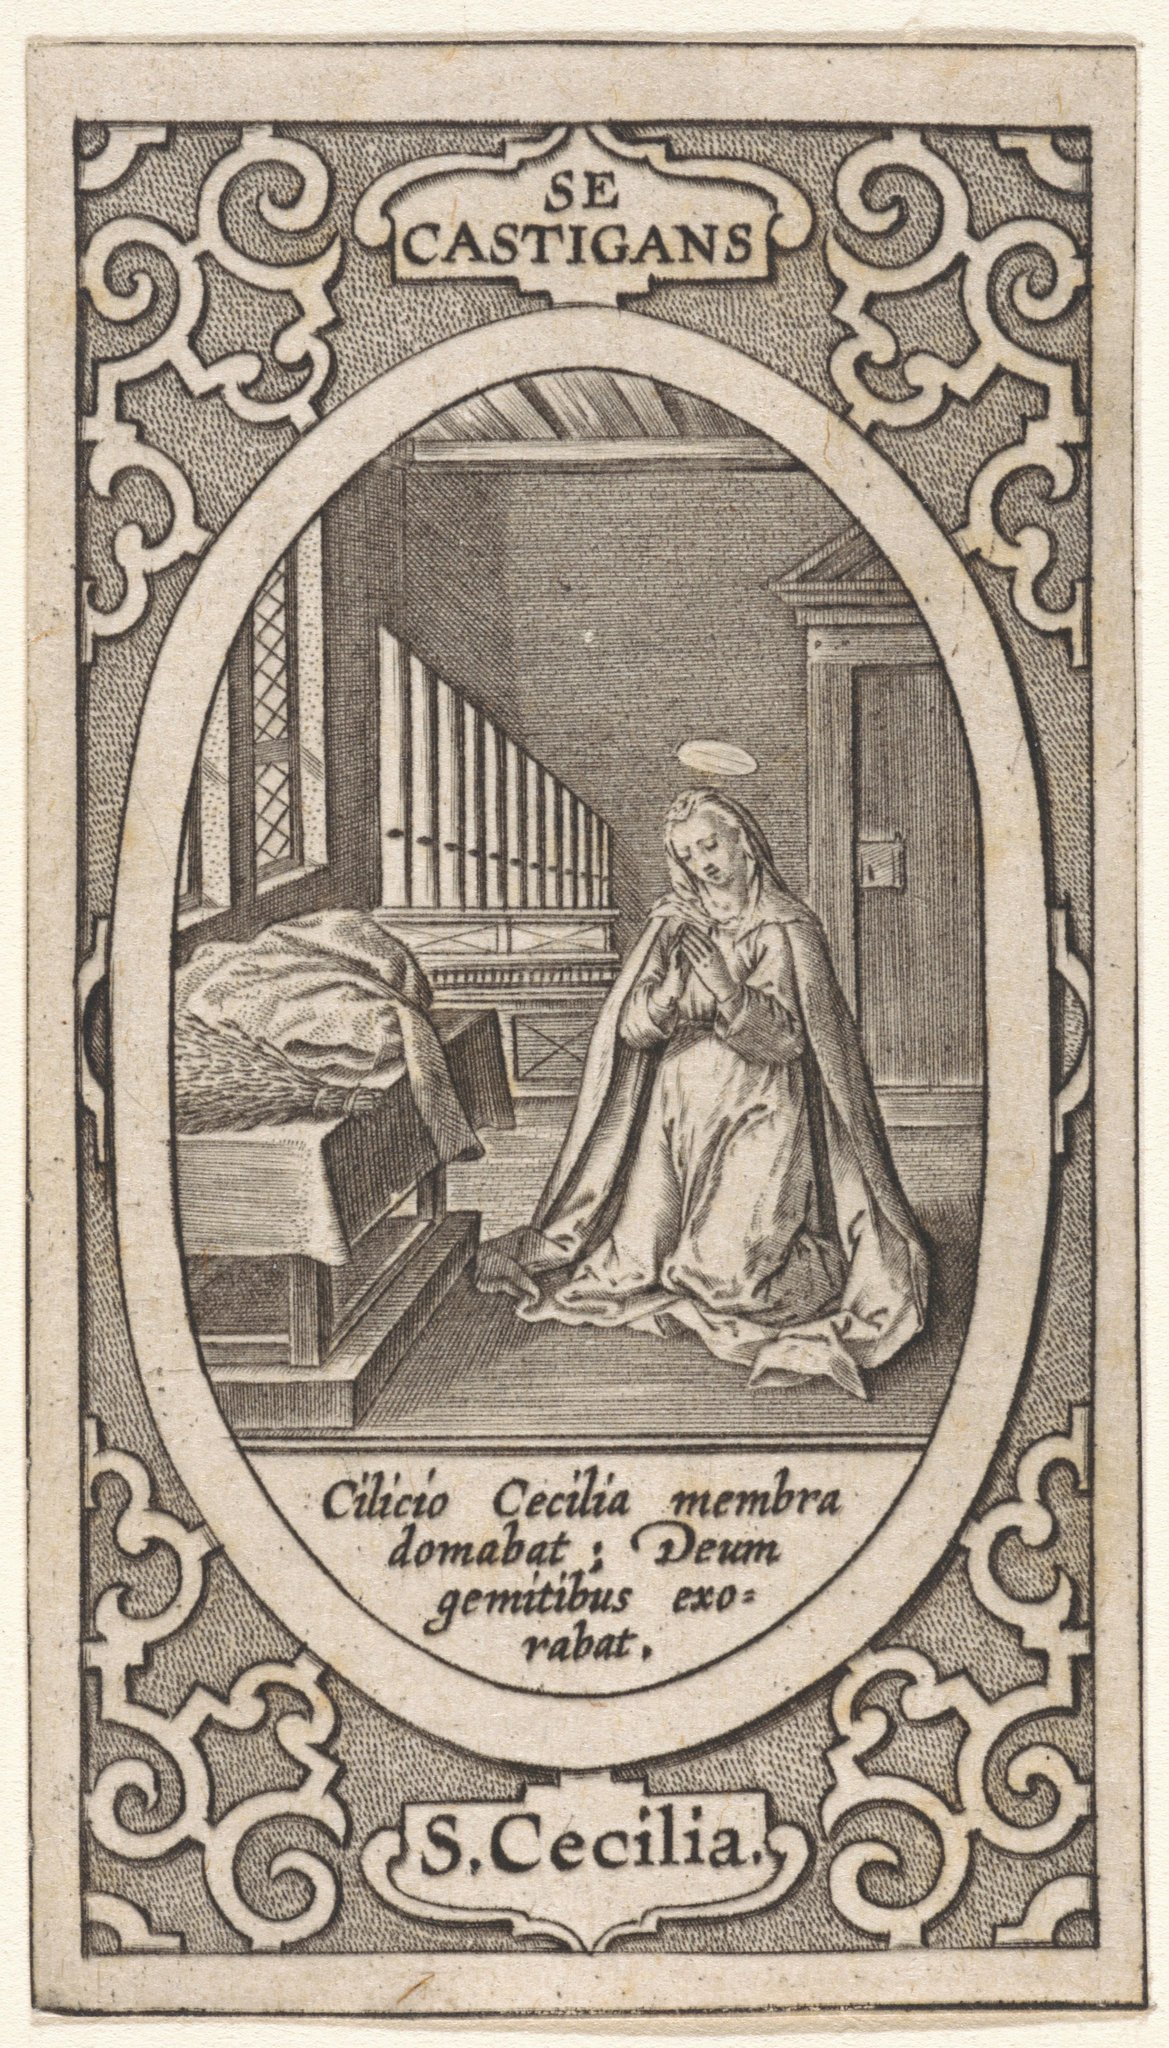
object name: print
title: H. Cecilia (Se Castigans)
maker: hieronymus wierix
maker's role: draughtsman, print maker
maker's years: 1553-1619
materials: paper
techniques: engraving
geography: antwerp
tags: the virgin martyr cecilia of rome; possible attributes: falcon, musical instruments, organ, wreath of roses and lilies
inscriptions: collector's mark: Lugt 2773, collector's mark: Lugt 2228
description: De prent is een fragment van een prent die oorspronkelijk bestaat uit een voorstelling van Maria met het Christuskind, omringd door scènes die deugdzaamheid illustreren.